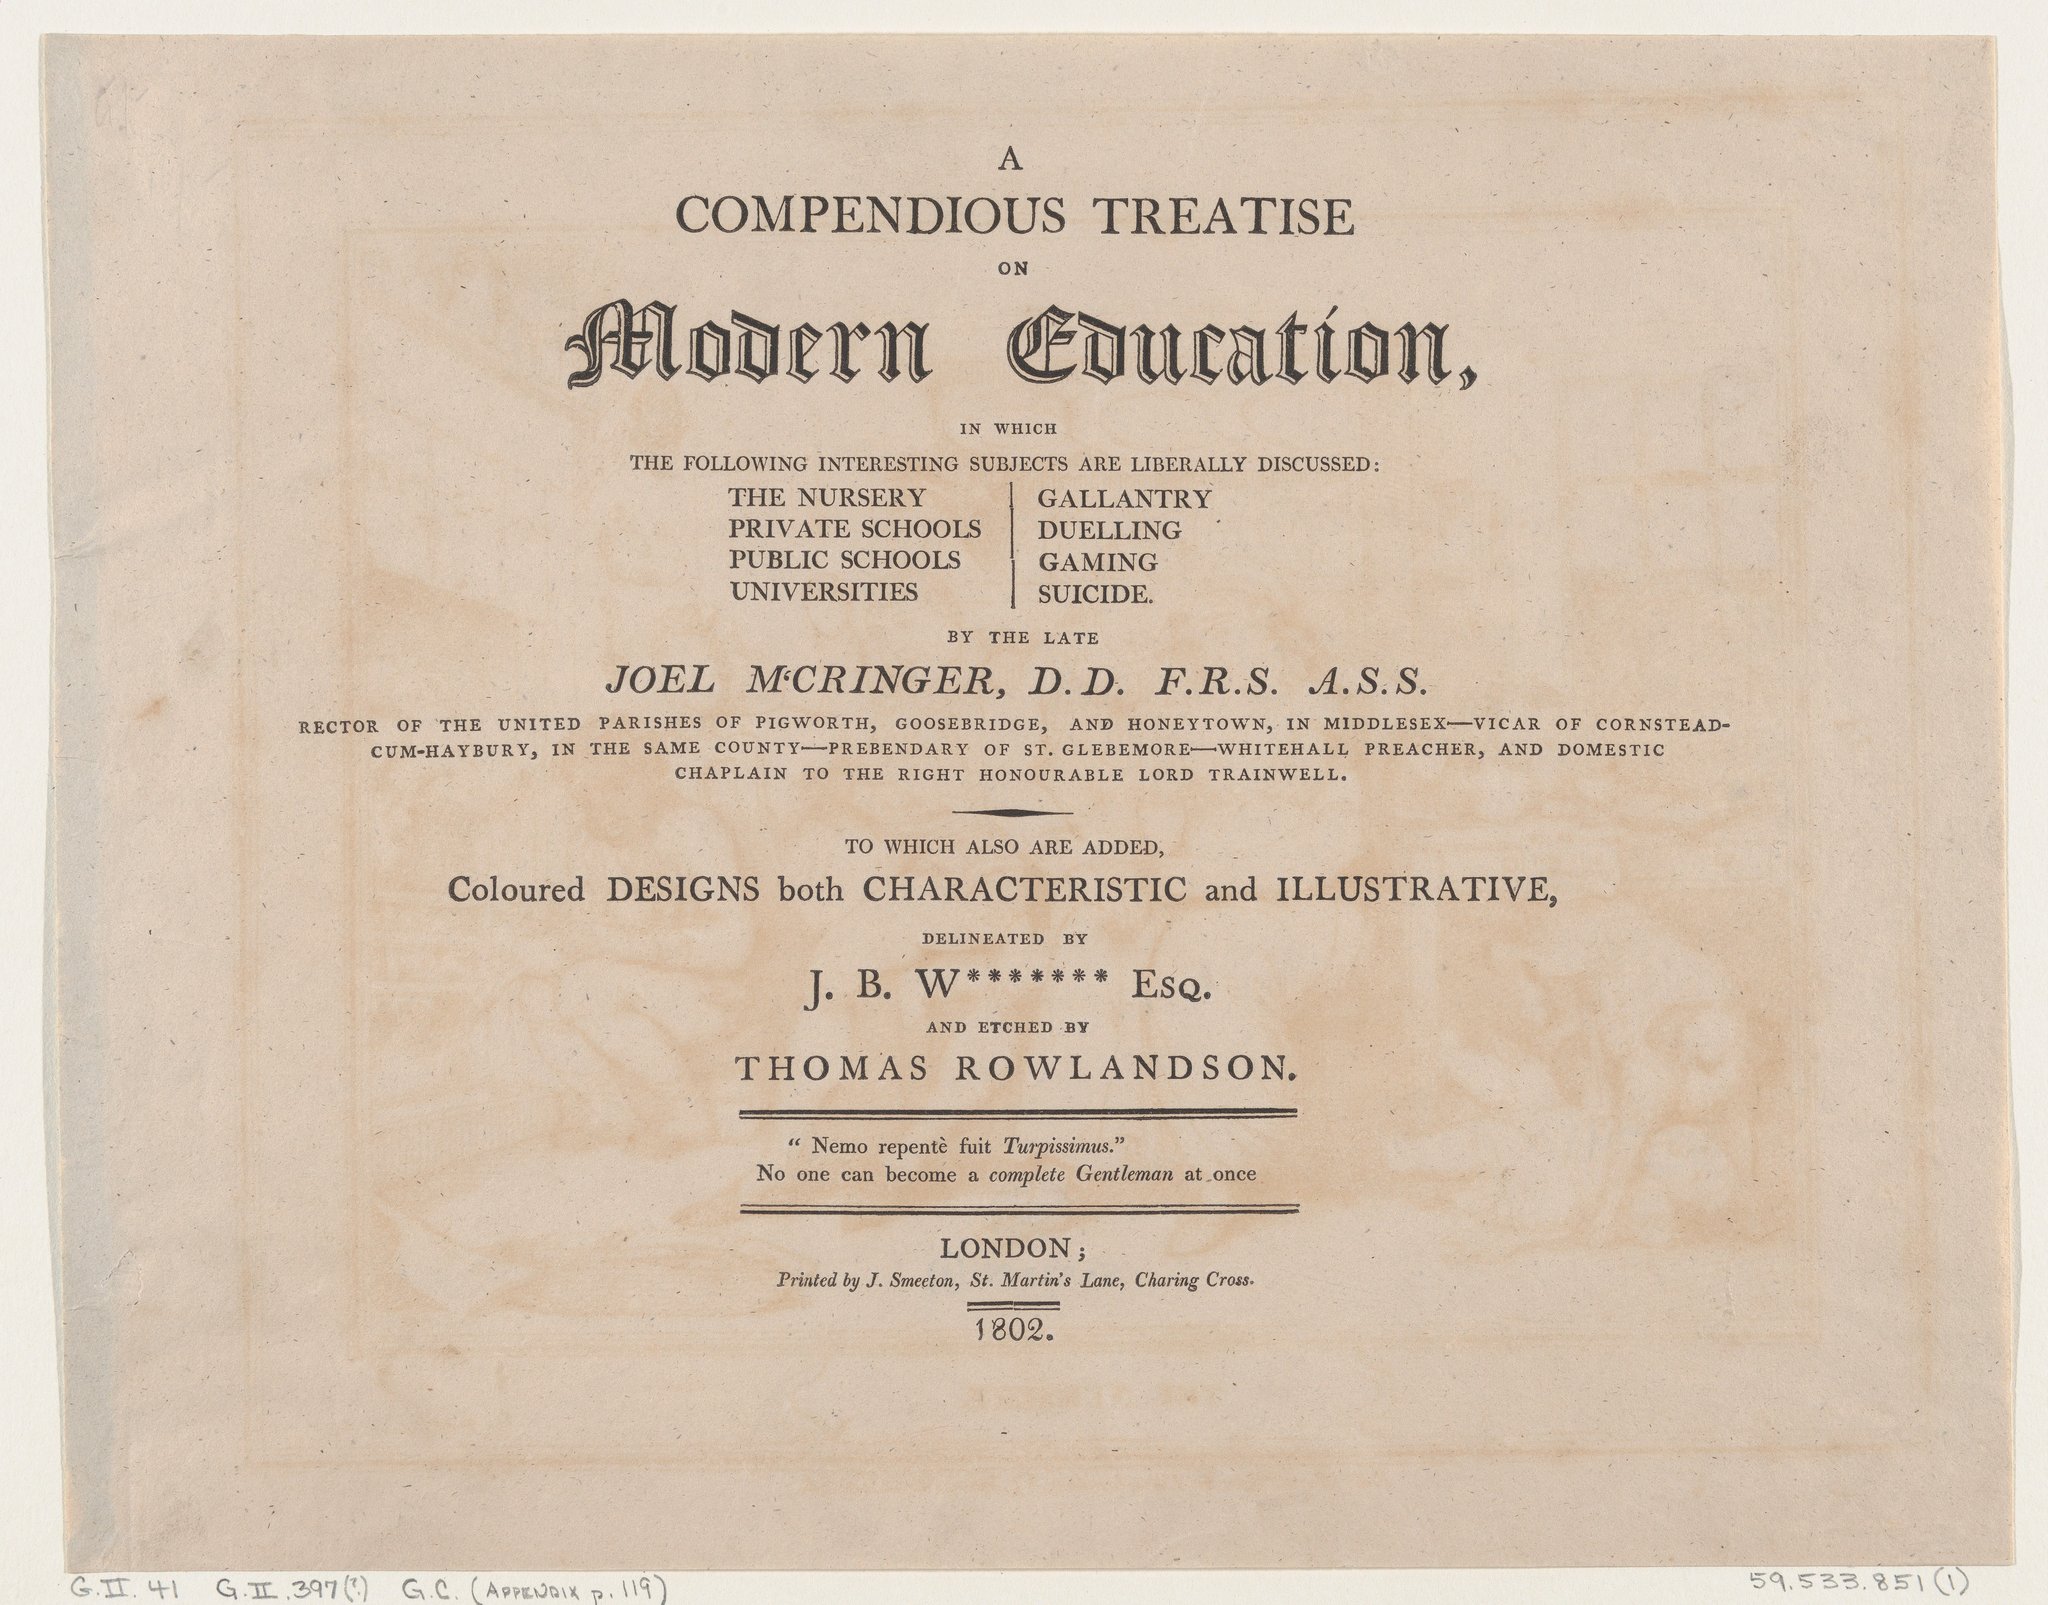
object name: print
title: A Compendious Treatise on Modern Education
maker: thomas rowlandson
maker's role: artist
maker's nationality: british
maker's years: 1757-1827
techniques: etching